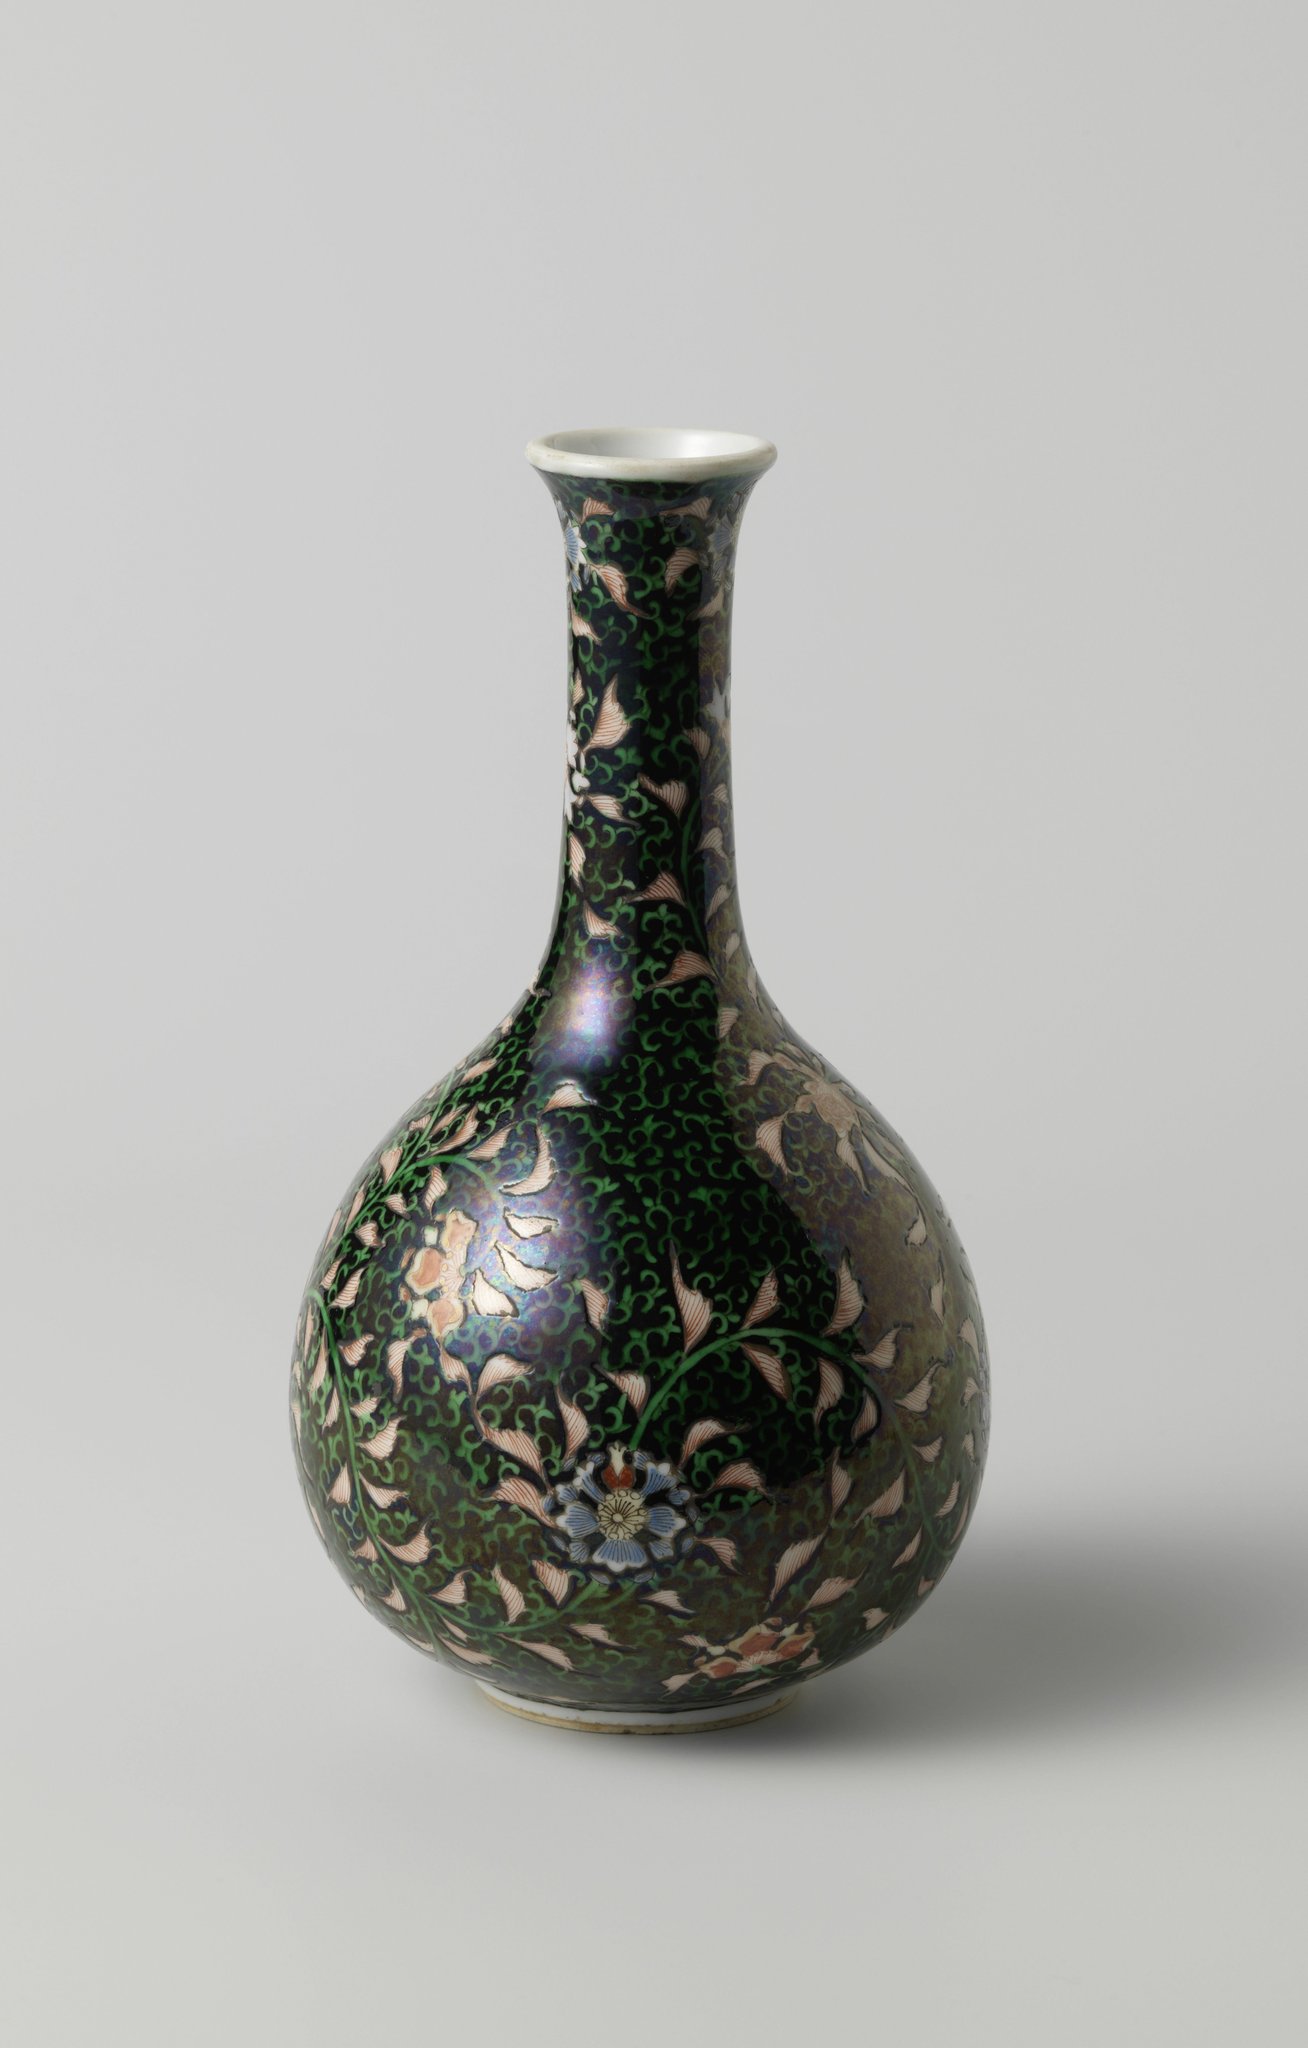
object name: bottle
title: Pear-shaped bottle vase with flower scrolls on a black ground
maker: Anonymous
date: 1725-1749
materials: glaze, gold, paint, porcelain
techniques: firing, gilding, turning, vitrification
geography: china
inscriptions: label: ‘R. May/ Vrienden der Aziatische Kunst’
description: Flesvormige vaas van porselein met peervormige buik en spreidende nek, beschilderd op het glazuur in blauw, rood, geel, groen en goud met bloemranken tegen een zwarte grond. Oud label op de onderzijde met 'R. May Vrienden der Aziatische Kunst'. Famille noir.